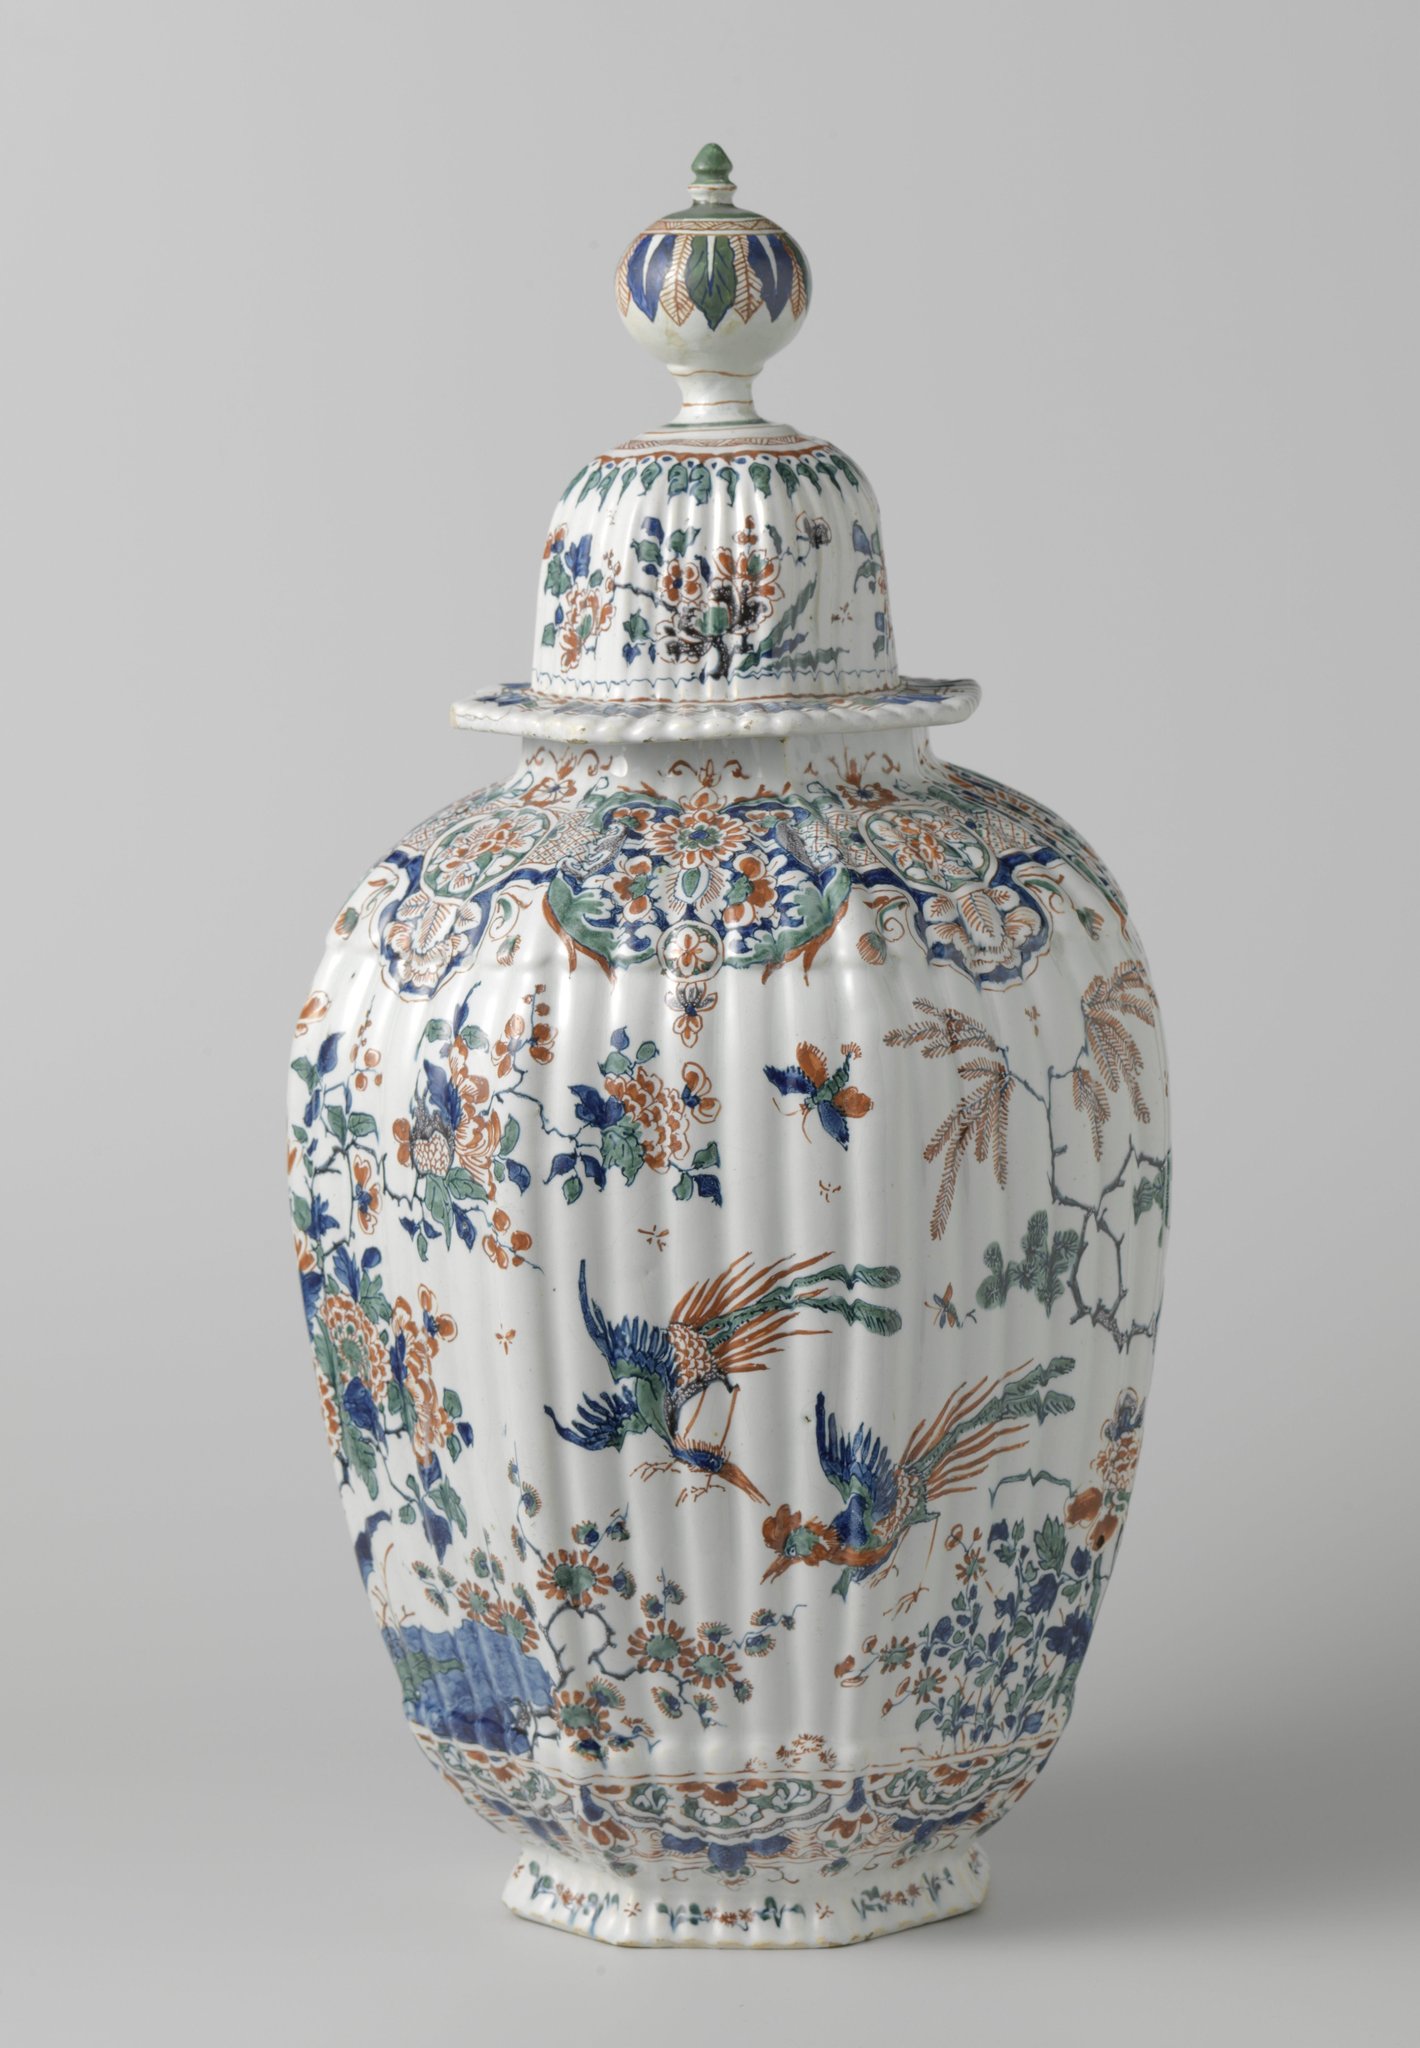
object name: kaststel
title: Achtkantige geribde vaas met deksel van veelkleurig beschilderde faïence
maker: lambertus van eenhoorn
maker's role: plateelbakker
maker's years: 1651-1721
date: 1695-1725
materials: earthenware, glaze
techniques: painted, polychromy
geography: delft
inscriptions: collector's mark: ‘collection J.F. Loudon’, mark: ‘LVE (ineen)/ IVK/ 3/ c’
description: Achtkantige, geribde vaas van veelkleurig beschilderde faïence. De vaas is beschilderd met bloemen, rotsen, vogels en een vogel in een boom. De vaas is onderdeel van een stel, de andere delen zijn: drie identieke potten en een identieke vaas. De delen zijn gemerkt.